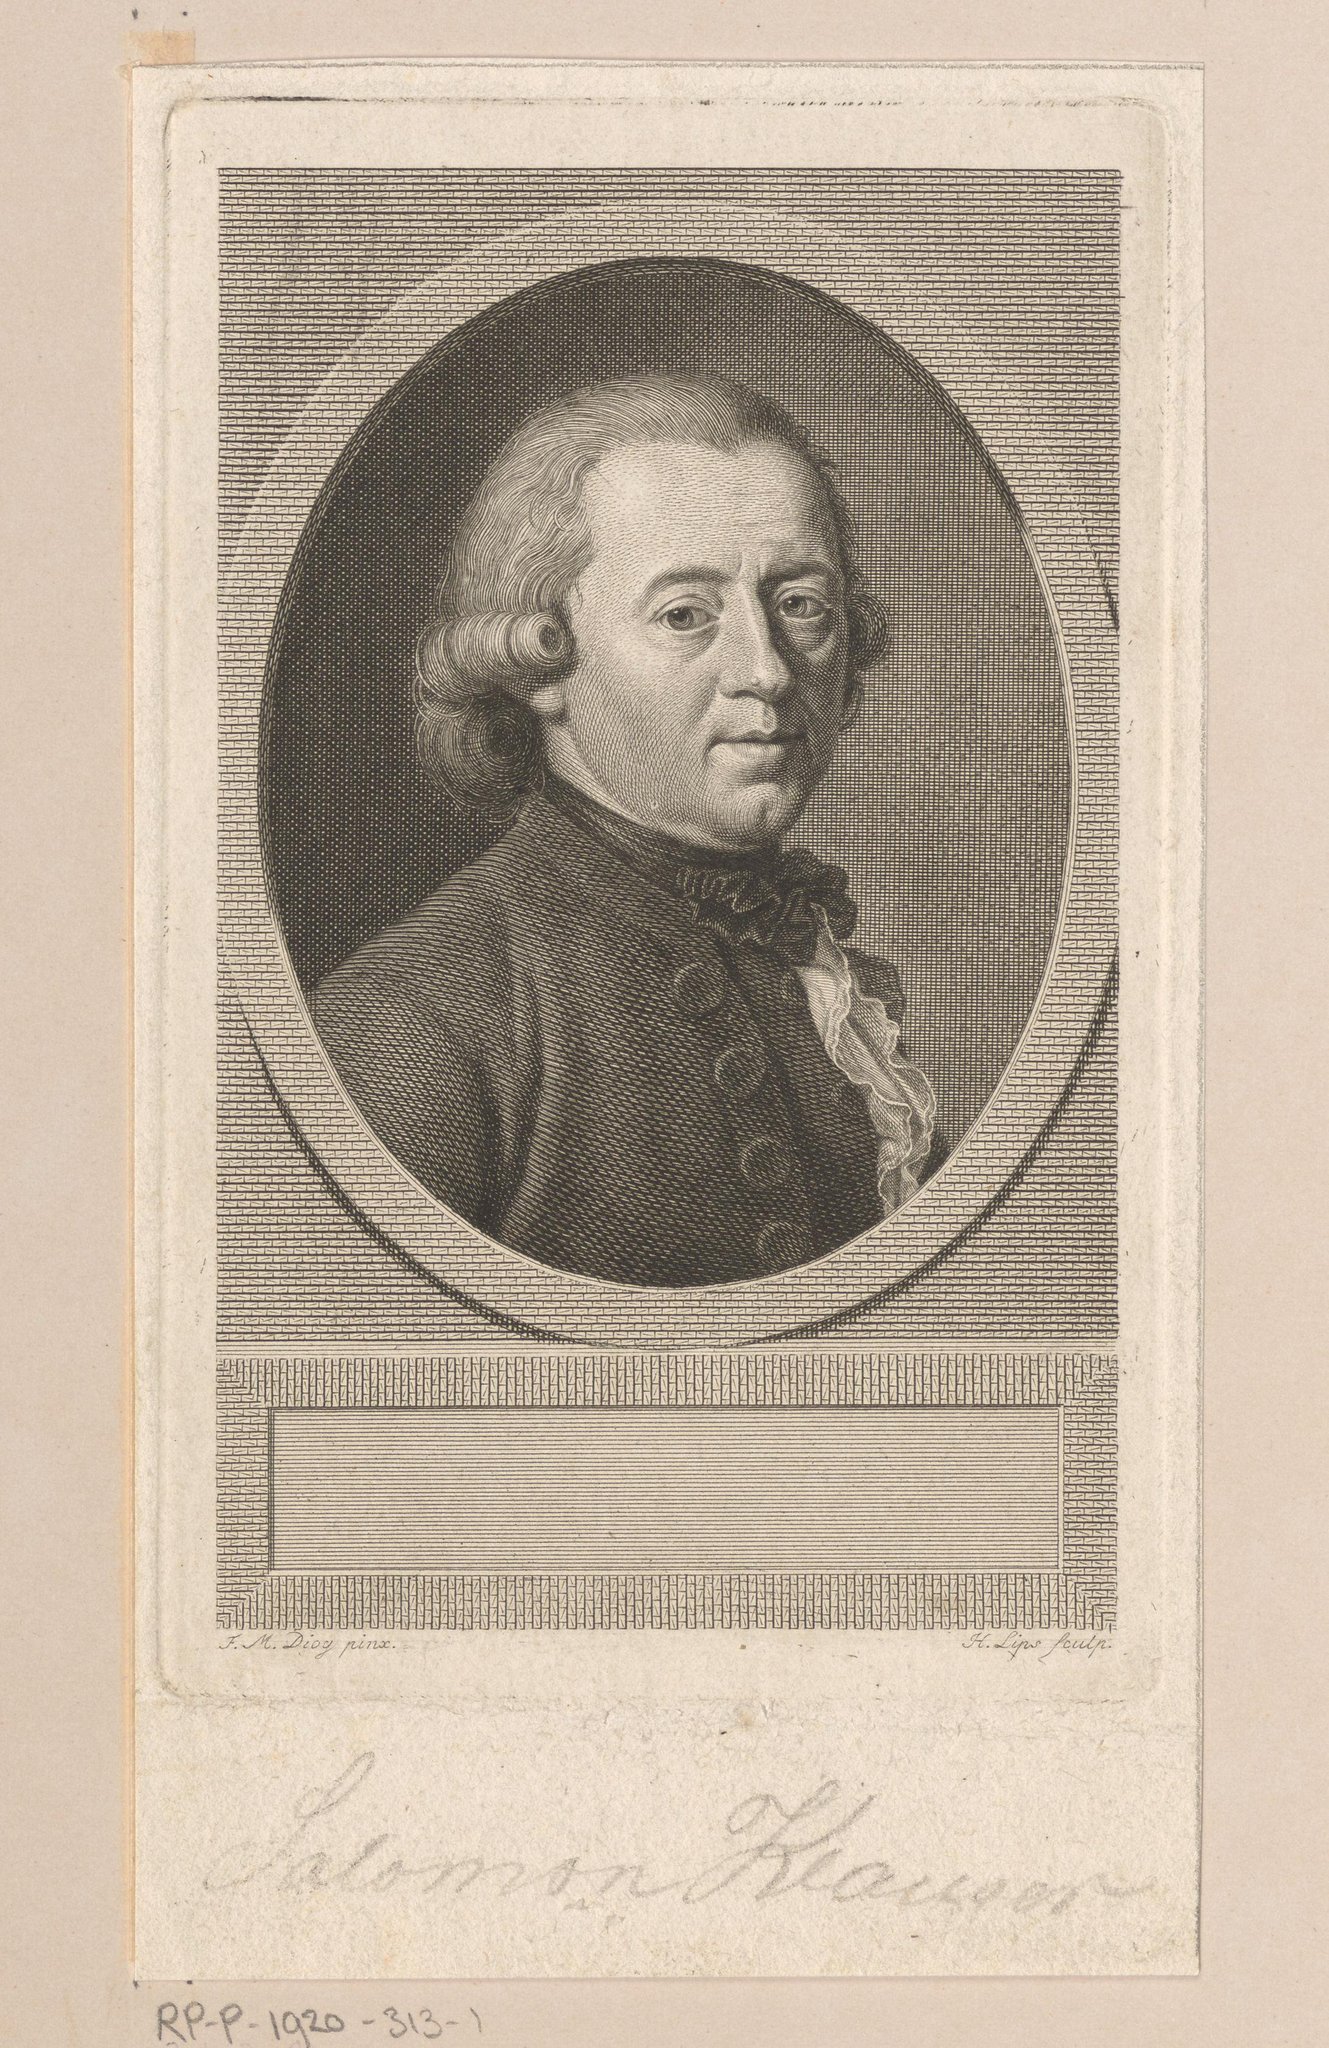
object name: print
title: Portret van Salomon Klauser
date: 1772-1817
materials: paper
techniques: engraving, etching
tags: historical persons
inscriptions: collector's mark: Lugt 2228